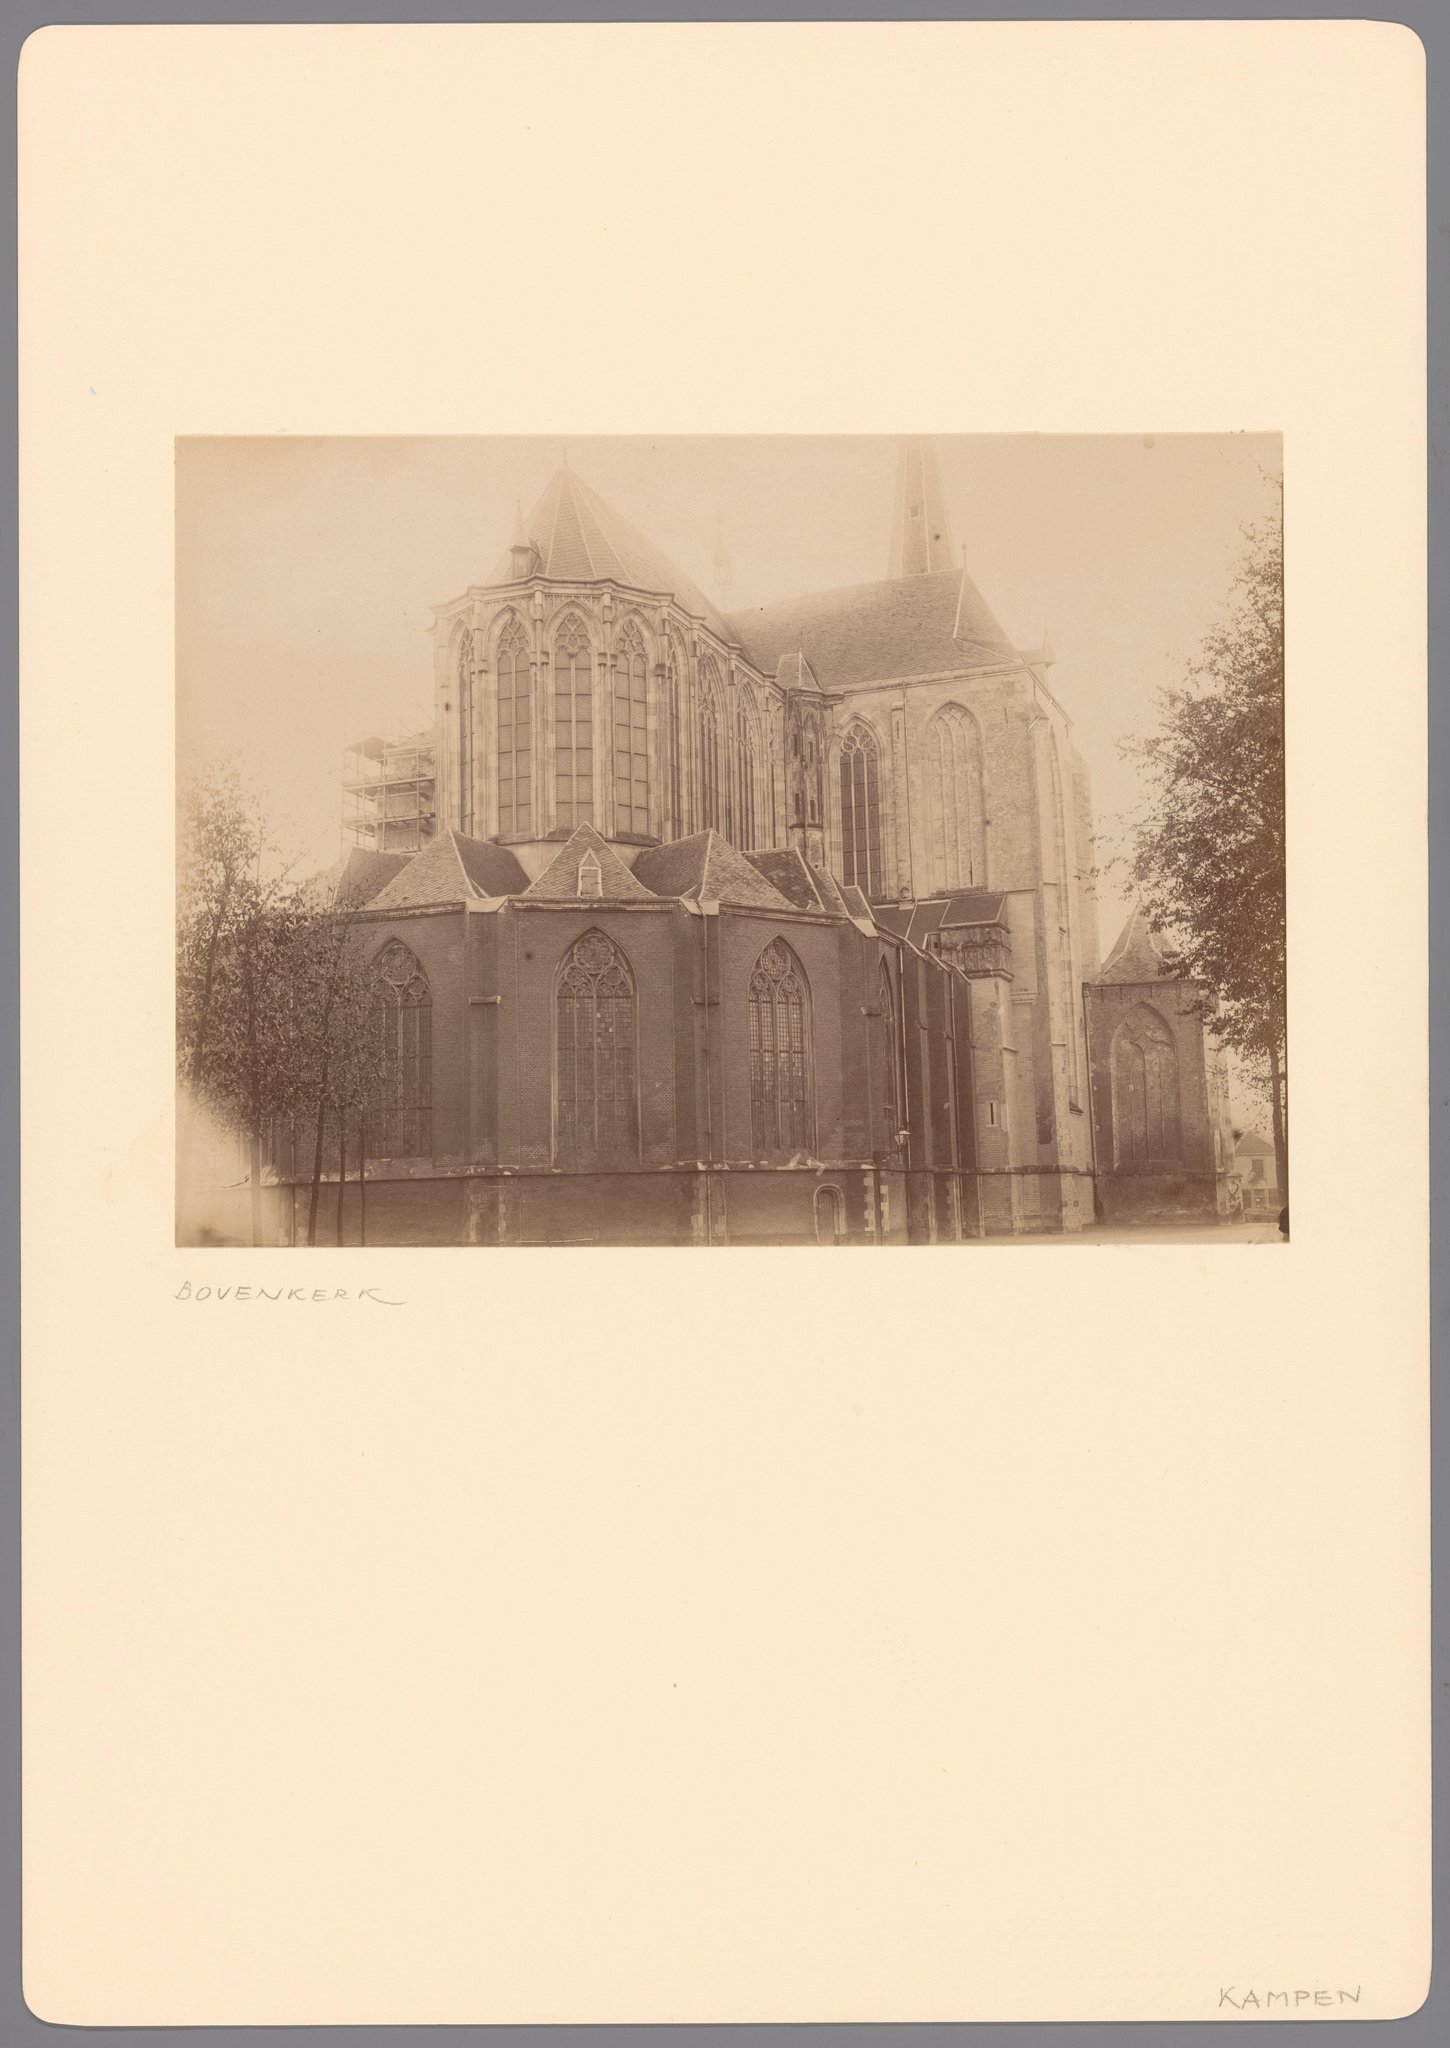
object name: photograph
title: Koor van de Bovenkerk te Kampen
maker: anoniem (monumentenzorg)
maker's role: fotograaf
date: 1891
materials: cardboard, photographic support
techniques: albumen print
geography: kampen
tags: parts of church exterior and annexes: choir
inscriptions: annotation: ‘Kampen-Bovenkerk/ kooraansicht/ oct 1891’, annotation: ‘Bovenkerk/ Kampen’